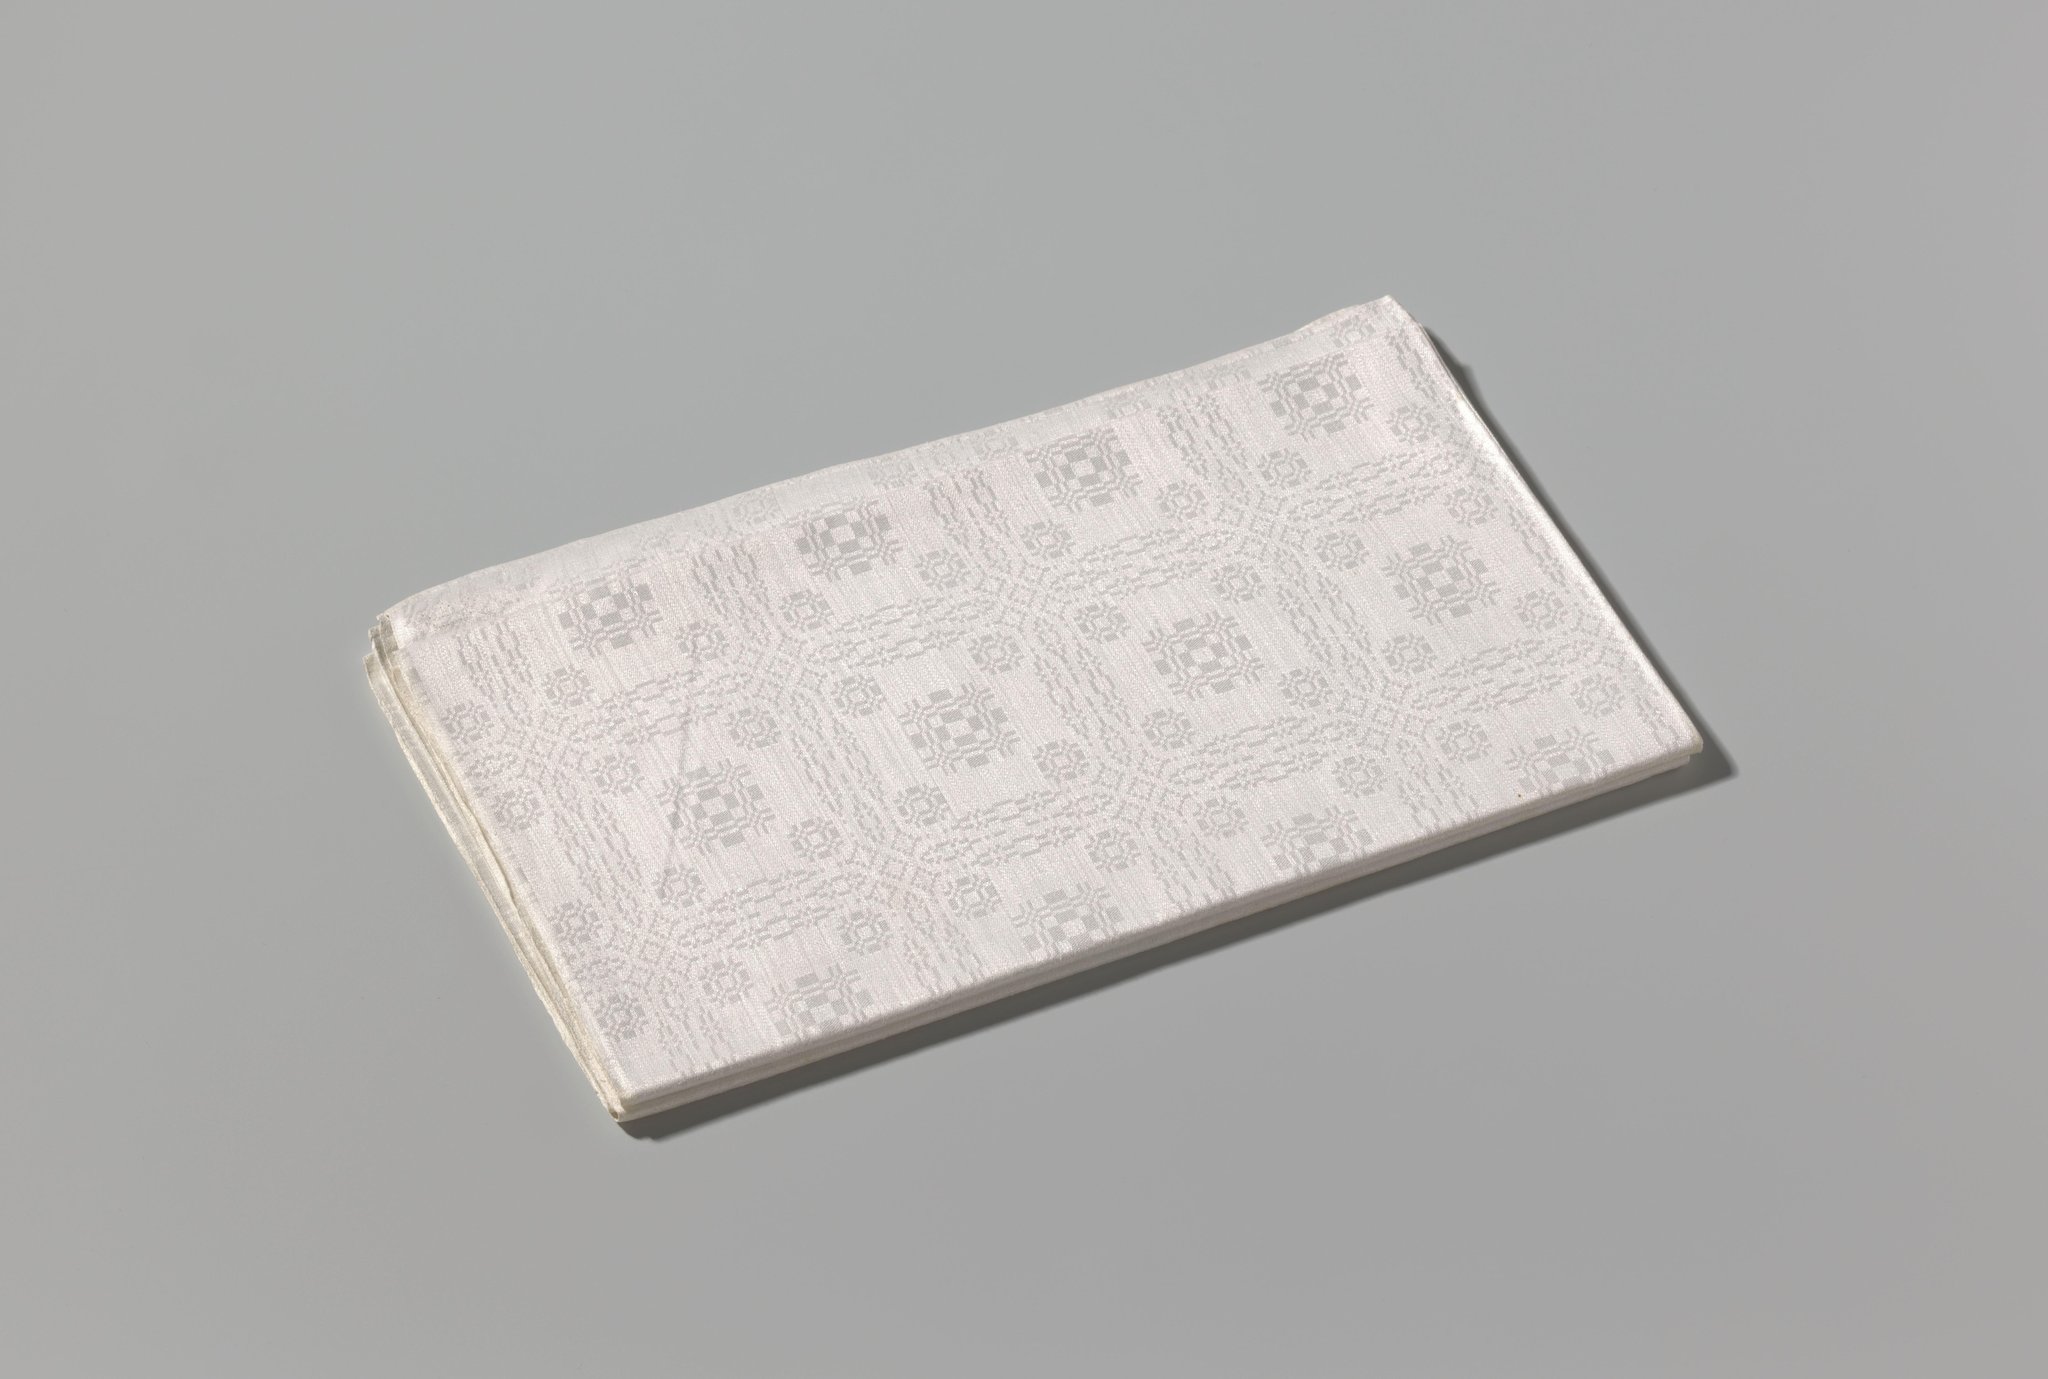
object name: tablecloth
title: Tafellaken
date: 1690-1710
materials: linen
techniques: peeled fabric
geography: northern netherlands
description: Wit linnen tafellaken met pellen patroon. Merk kroon G 4.